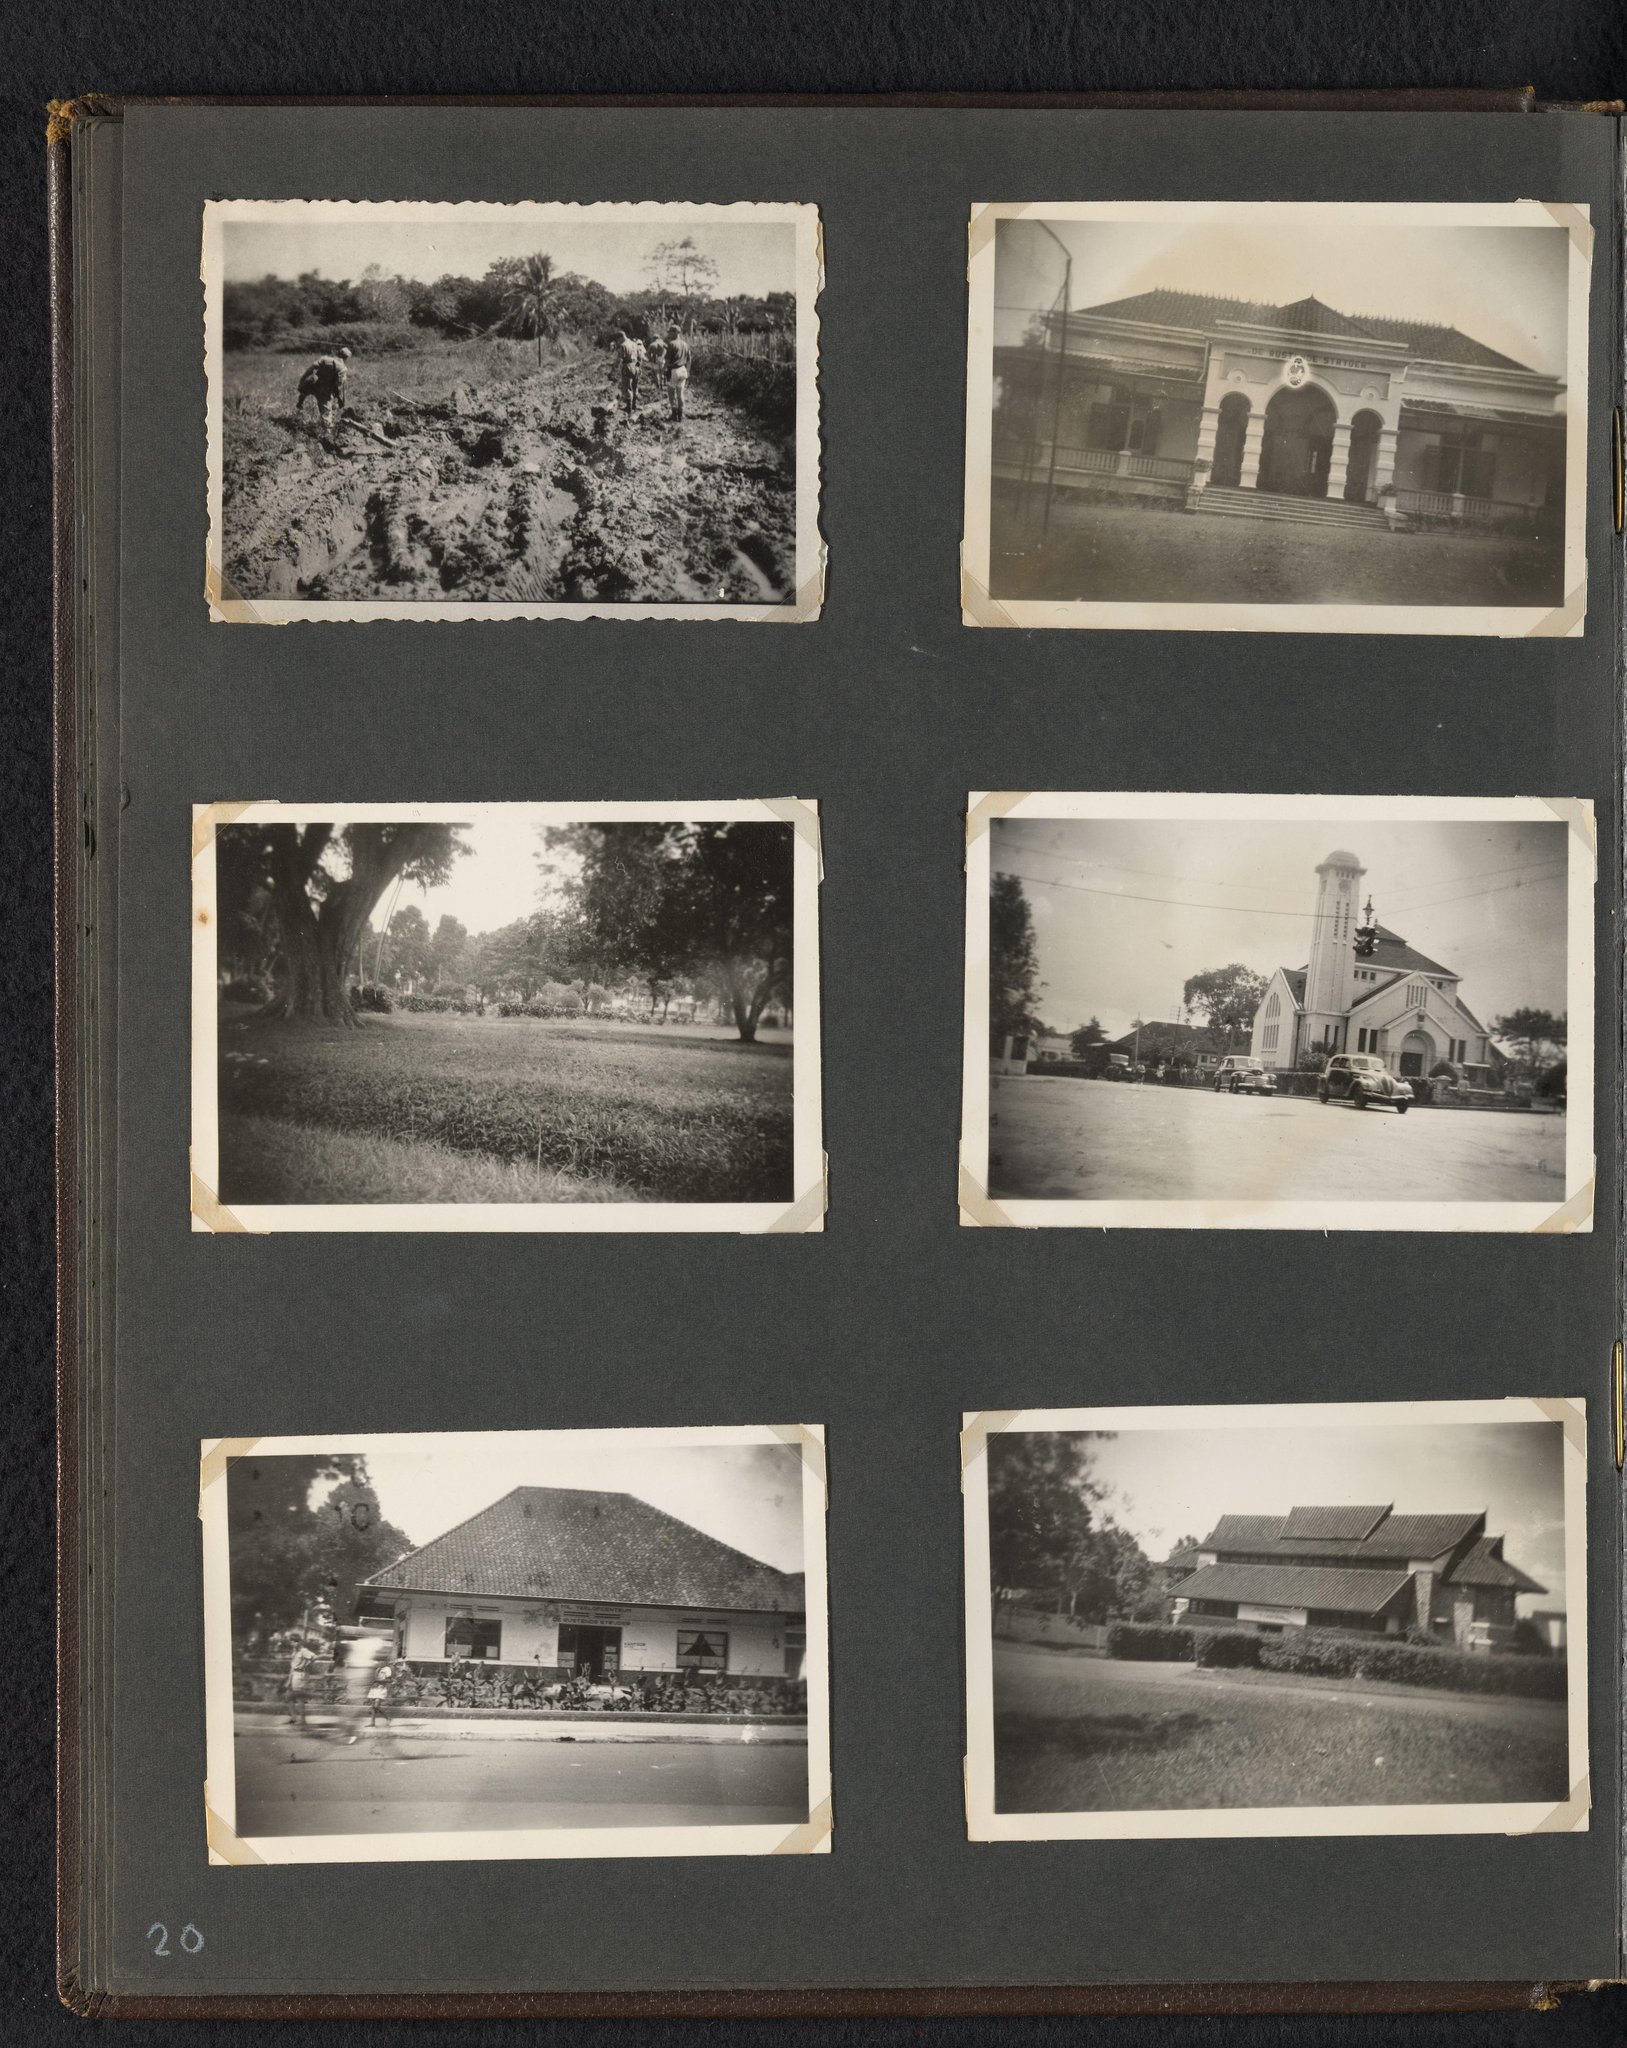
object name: album leaf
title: Bandoeng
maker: Anonymous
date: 1904-1949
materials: cardboard, photographic support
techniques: gelatin silver print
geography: bandung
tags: church (exterior), factories and mills in landscape, recreation ~ the soldier off duty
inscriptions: inscription: ‘...gal / Wandeling! na een regenbuitje / April 1949’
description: Albumblad met zes foto's te Bandoeng, wandeling door modder, het Militair Verlofcentrum de Rustende Strijder en en de Protestantse kerk. Onderdeel van het fotoalbum 'Mijn jaren in Indië' met foto's over de militaire acties in Nederlands-Indië.